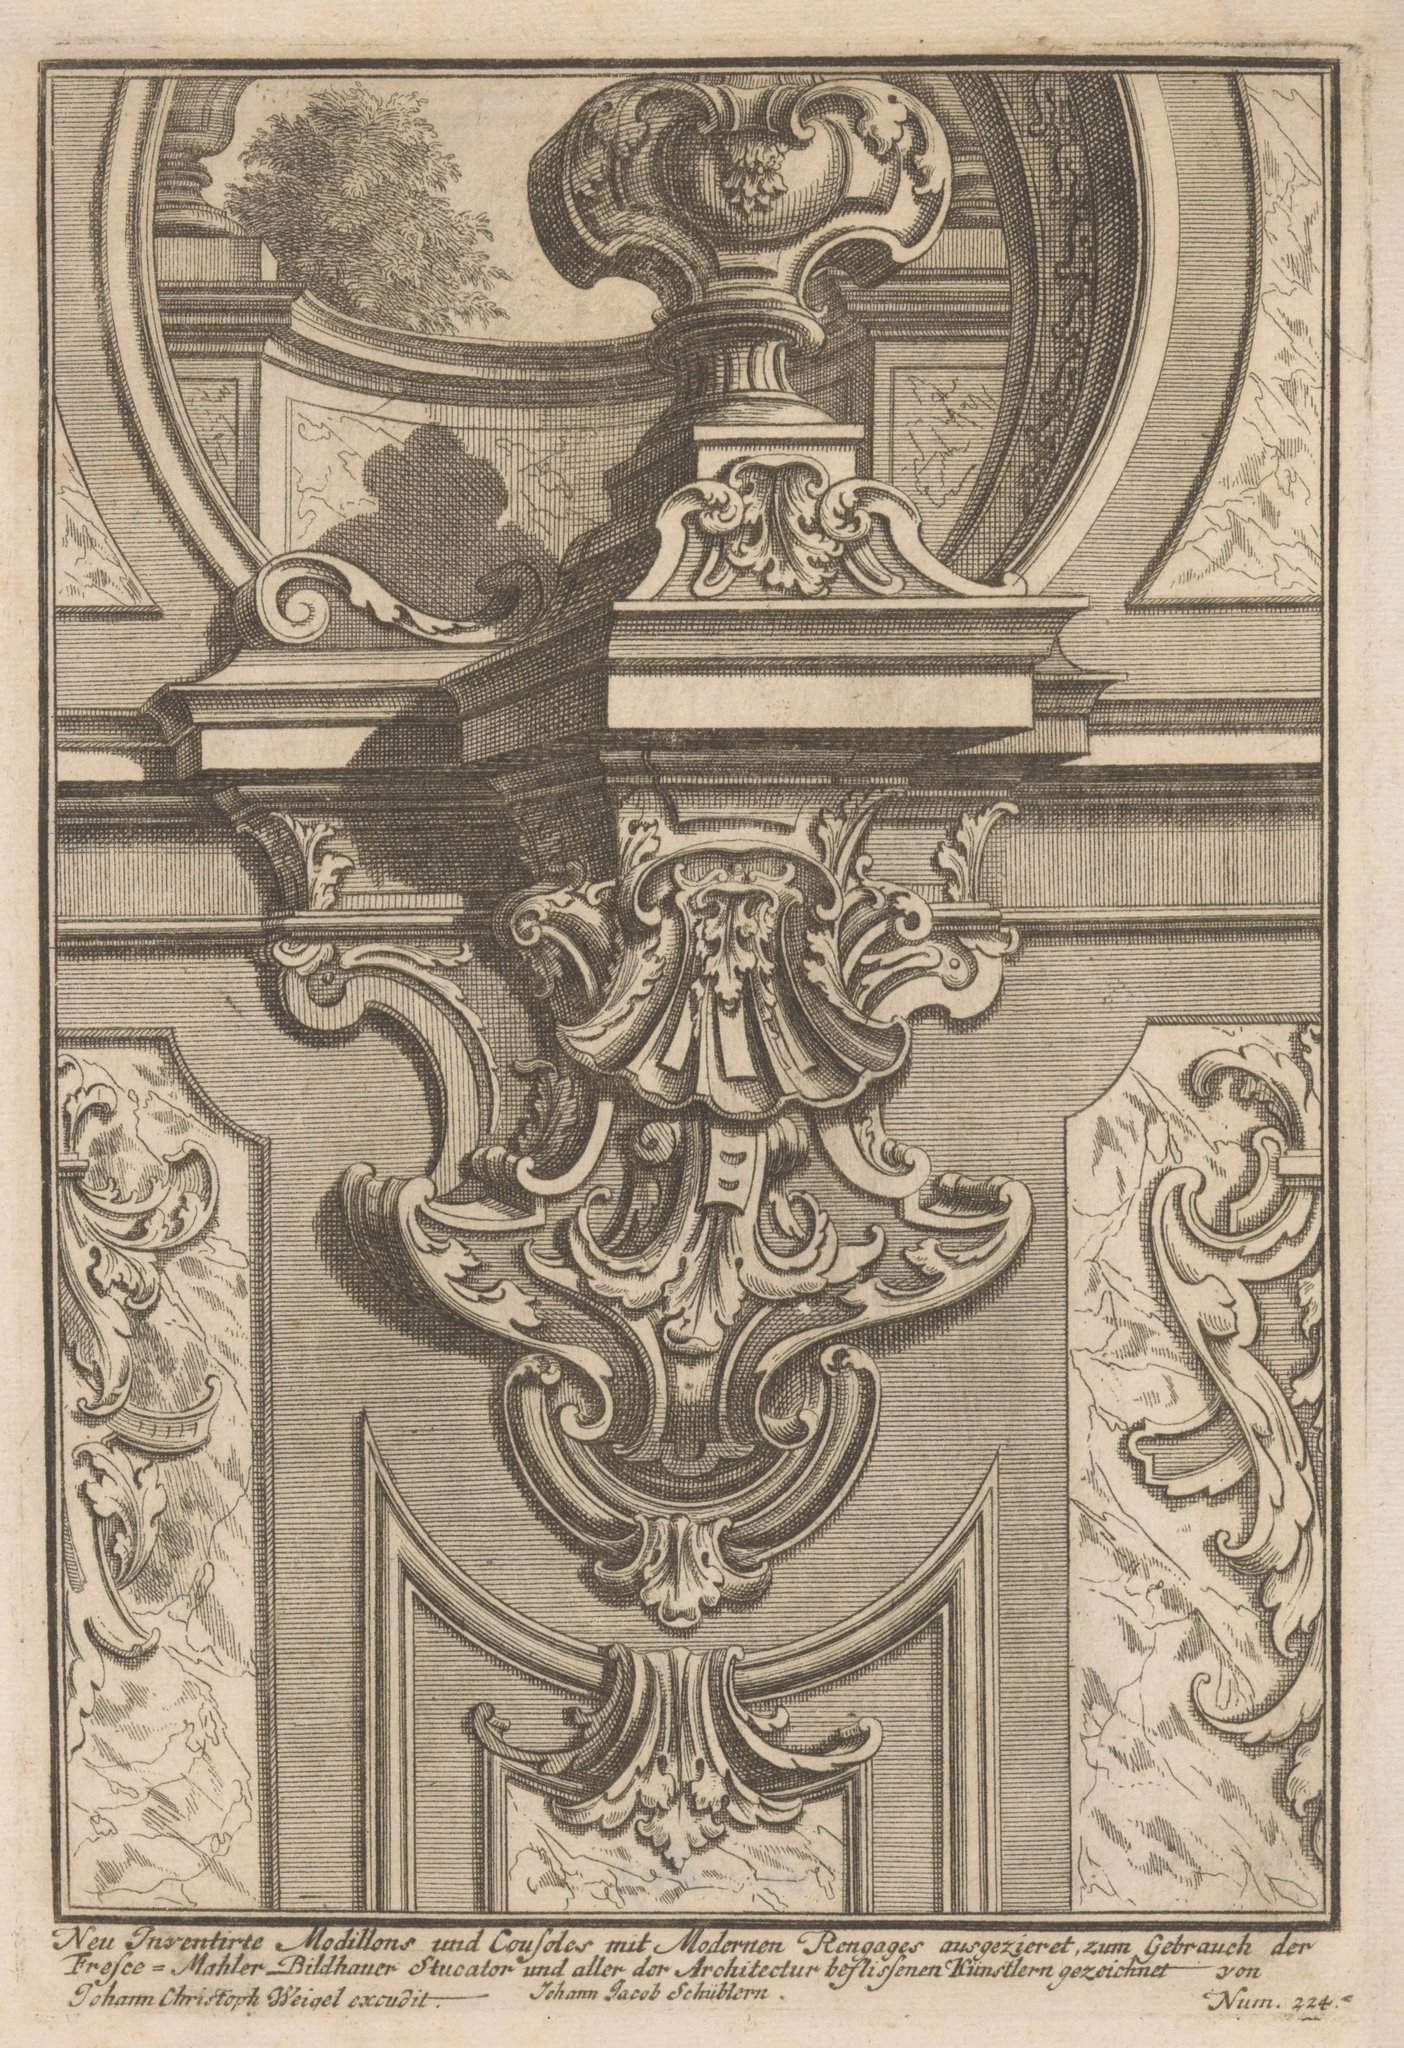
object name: ornament print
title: Neu Inventirte Modillons und Consoles (...)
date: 1699-1726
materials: paper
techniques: engraving, etching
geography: nuremberg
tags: other architectural details (console)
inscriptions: collector's mark: Lugt 2228, collector's mark: Lugt 2760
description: Een console met ornamenten, bladmotieven en een bekroning hangt tegen een wand met een ronde opening met doorkijk naar buiten. Uitgeversnummer 224.